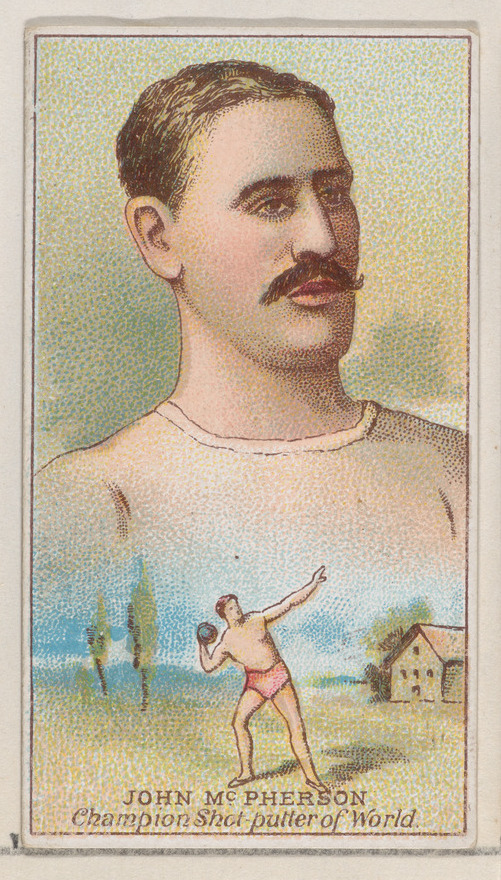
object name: print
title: John McPherson, Champion Shot-putter of the World, from the Champions of Games and Sports series (N184, Type 2) issued by W.S. Kimball & Co.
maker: w.s. kimball & co.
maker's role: publisher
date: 1887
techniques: color lithograph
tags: men,sports,athletes